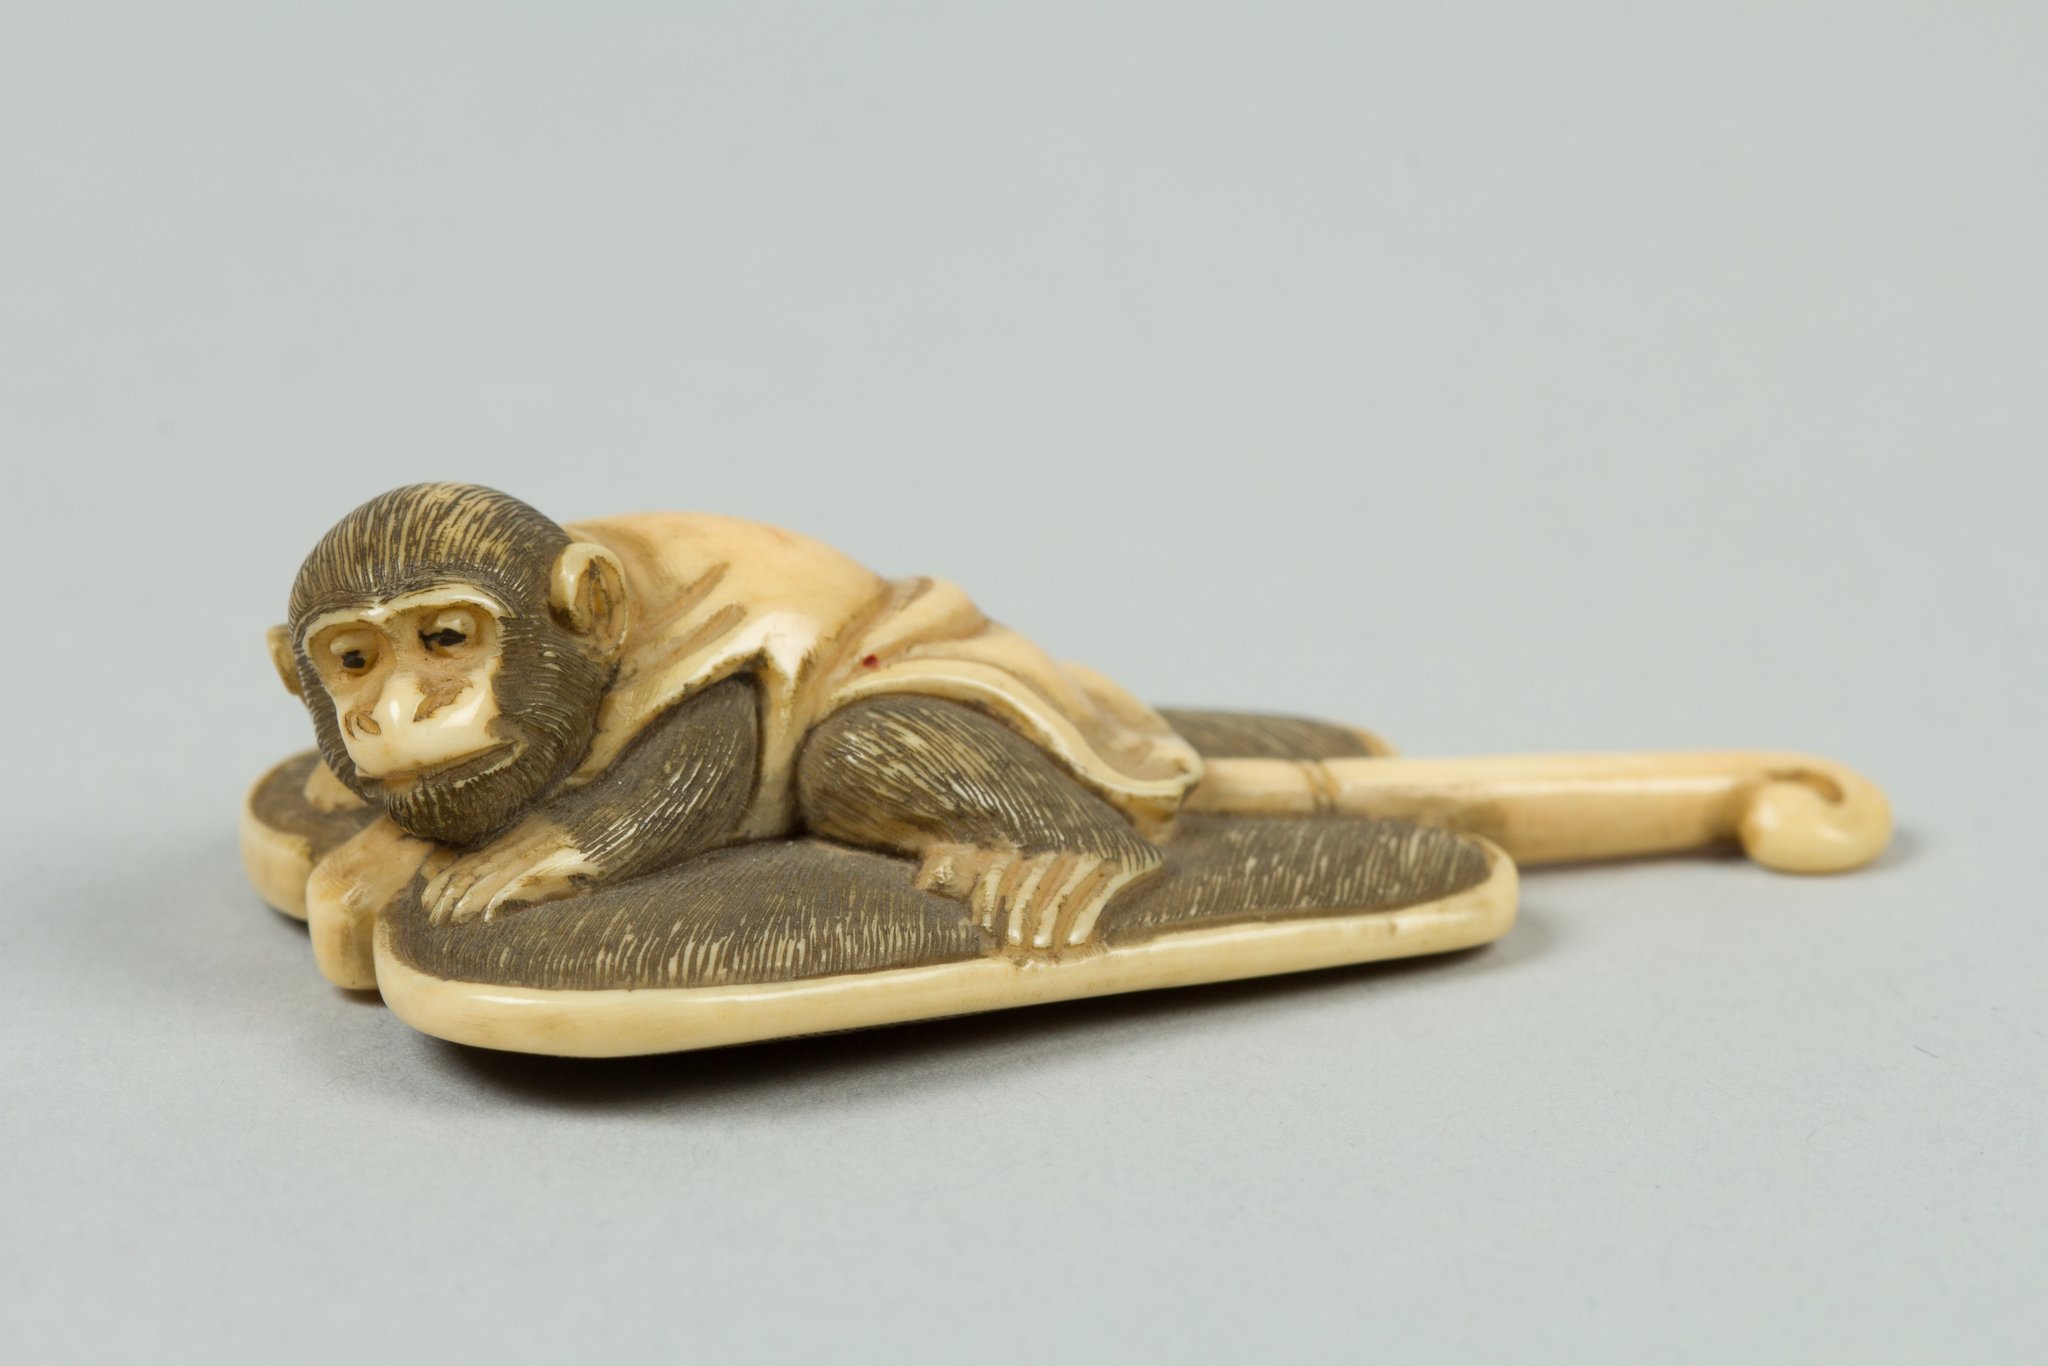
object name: netsuke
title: Netsuke of Monkey on a Bamboo Fan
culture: japanese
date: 1801-1900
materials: ivory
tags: monkeys